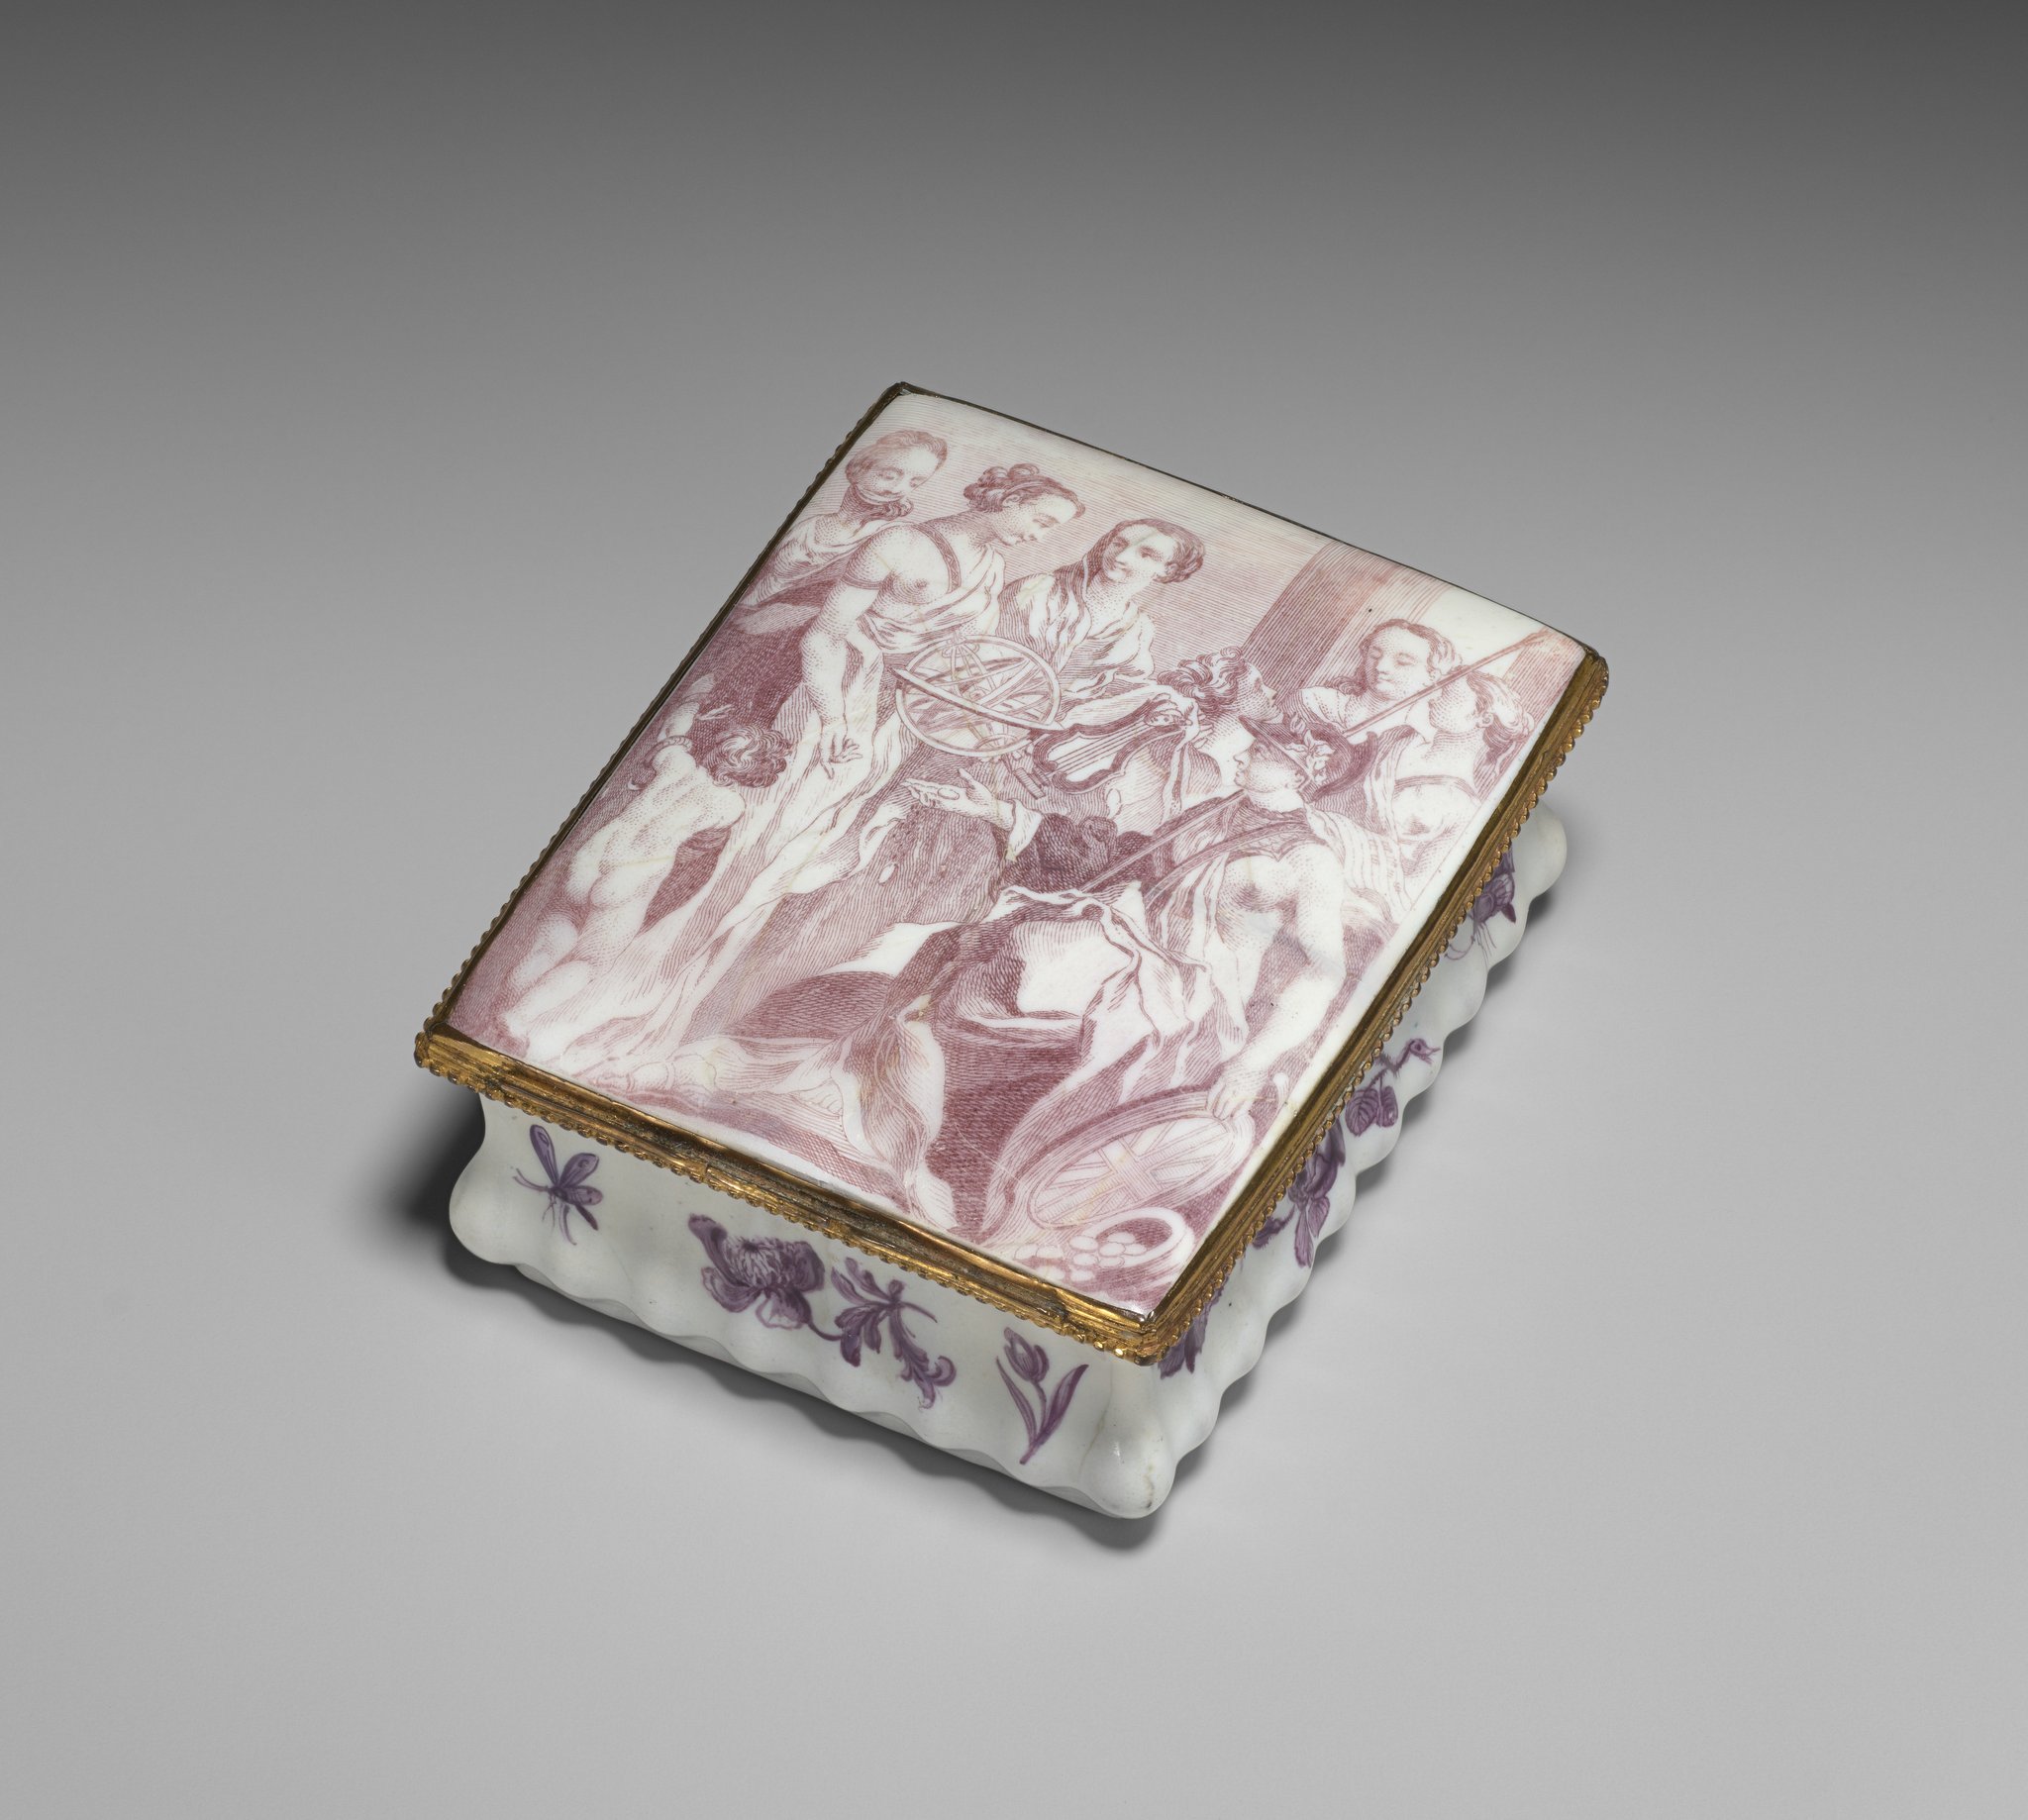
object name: snuffbox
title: Britannia giving coins to Science and the Arts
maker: simon francis ravenet, the elder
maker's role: artist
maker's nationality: french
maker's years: 1706-1774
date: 1753-1756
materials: copper, enamel